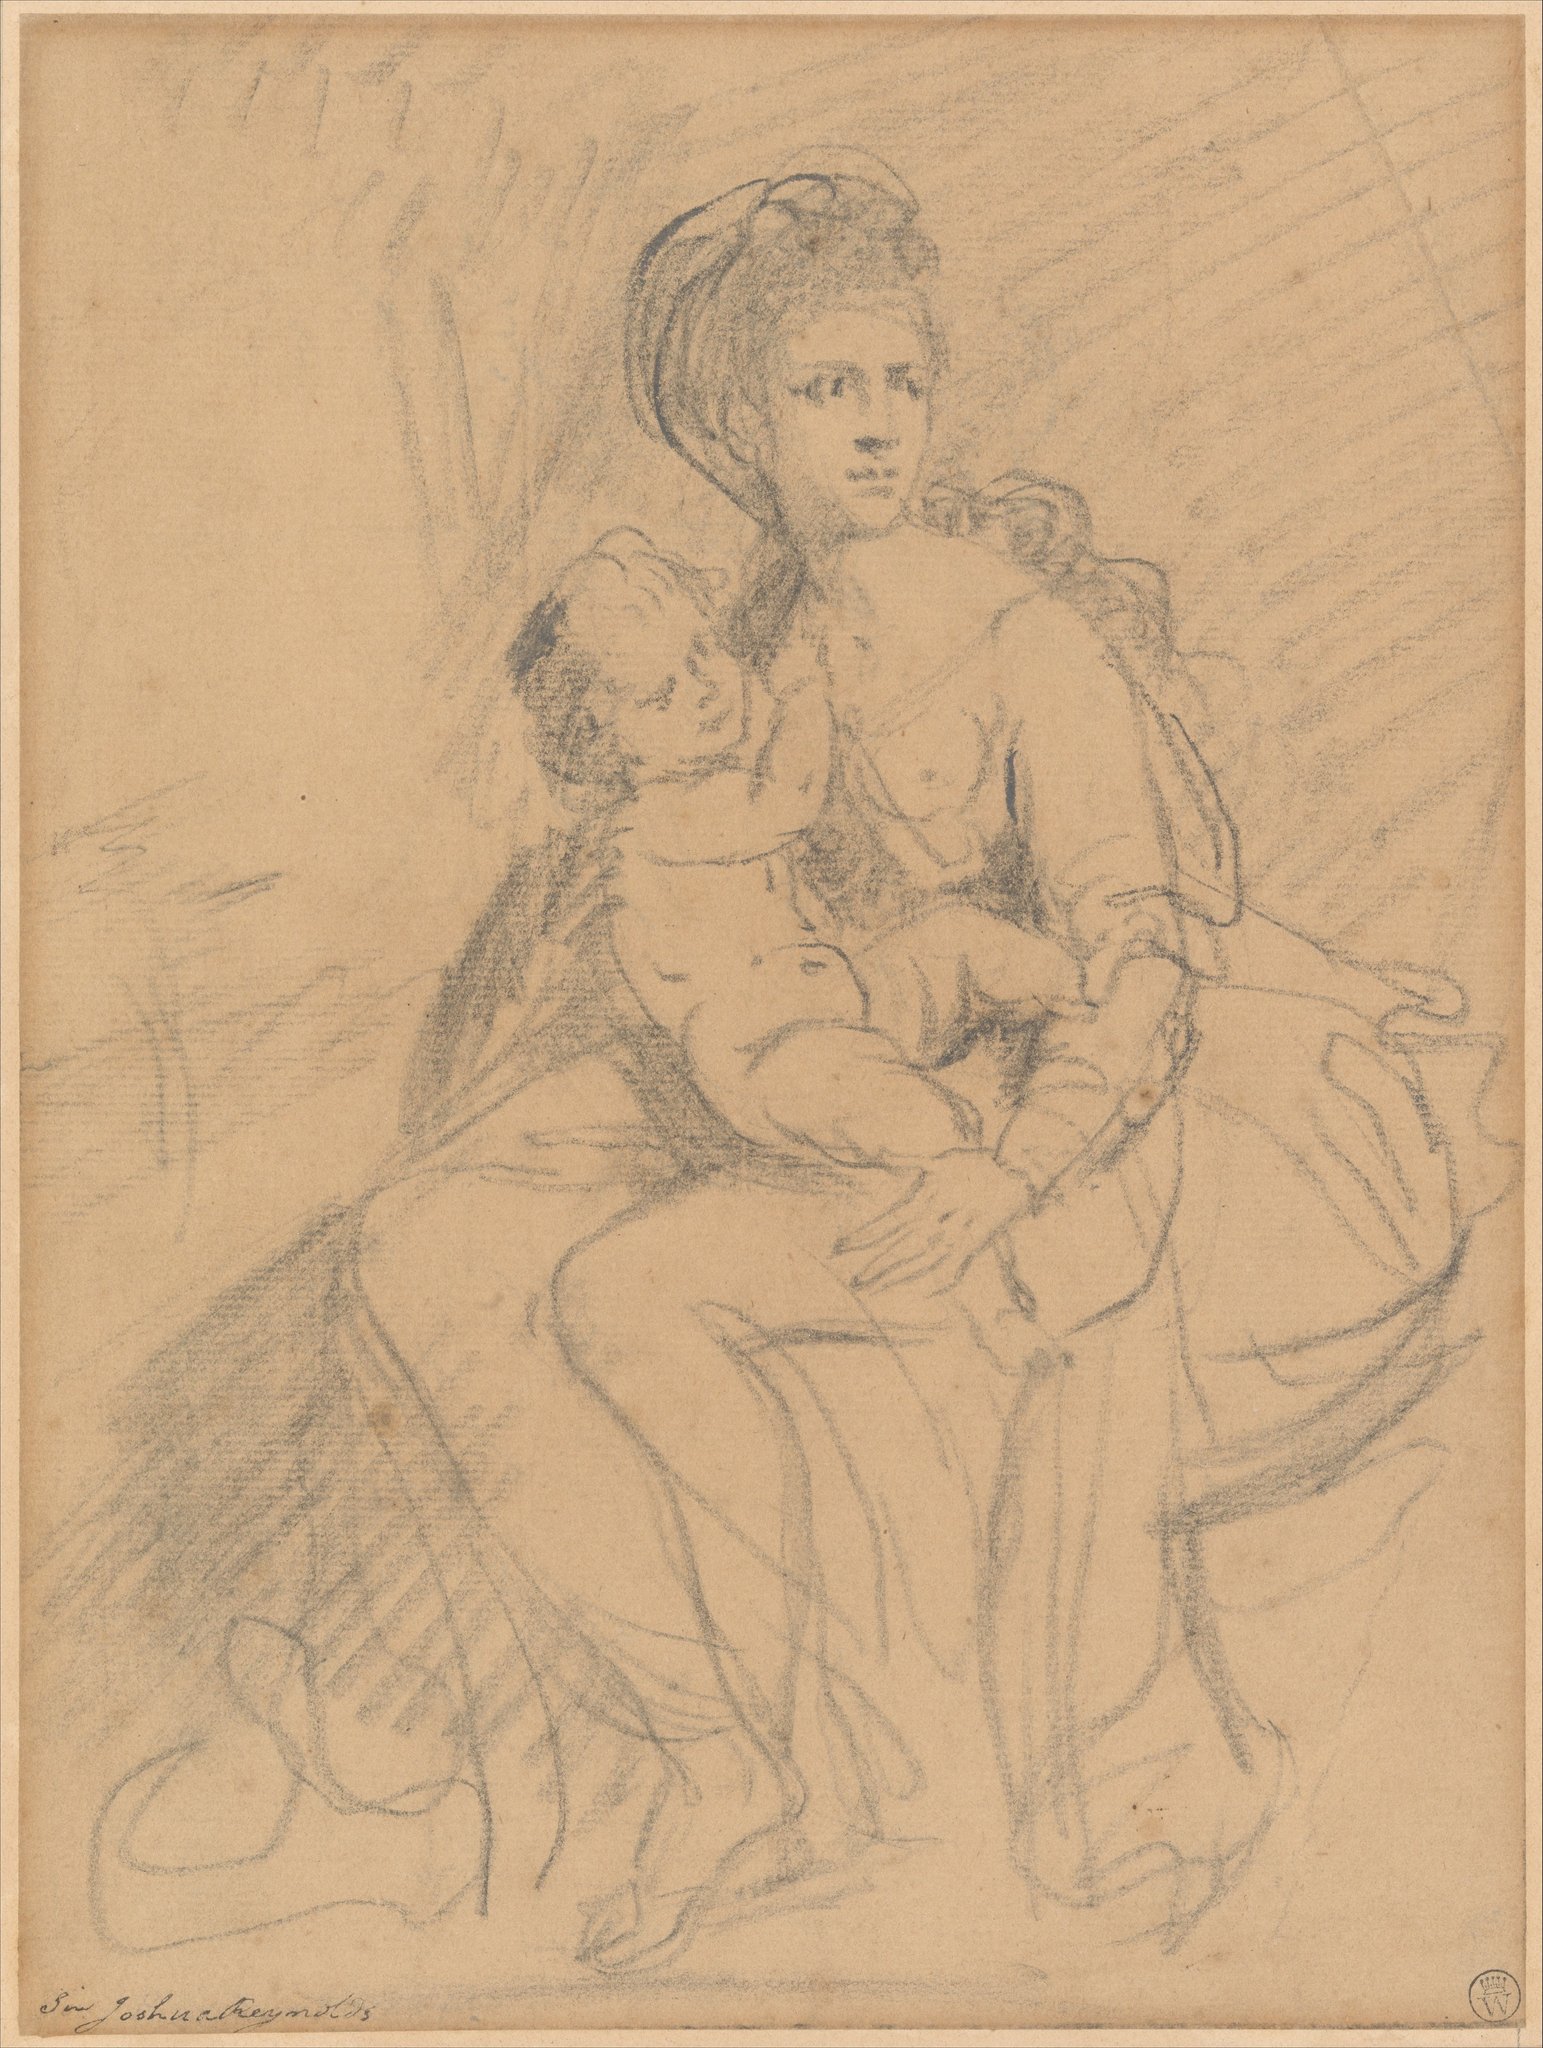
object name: drawing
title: Study of a woman and child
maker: sir joshua reynolds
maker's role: artist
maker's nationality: british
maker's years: 1723-1792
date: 1745-1792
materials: chalk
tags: children,women